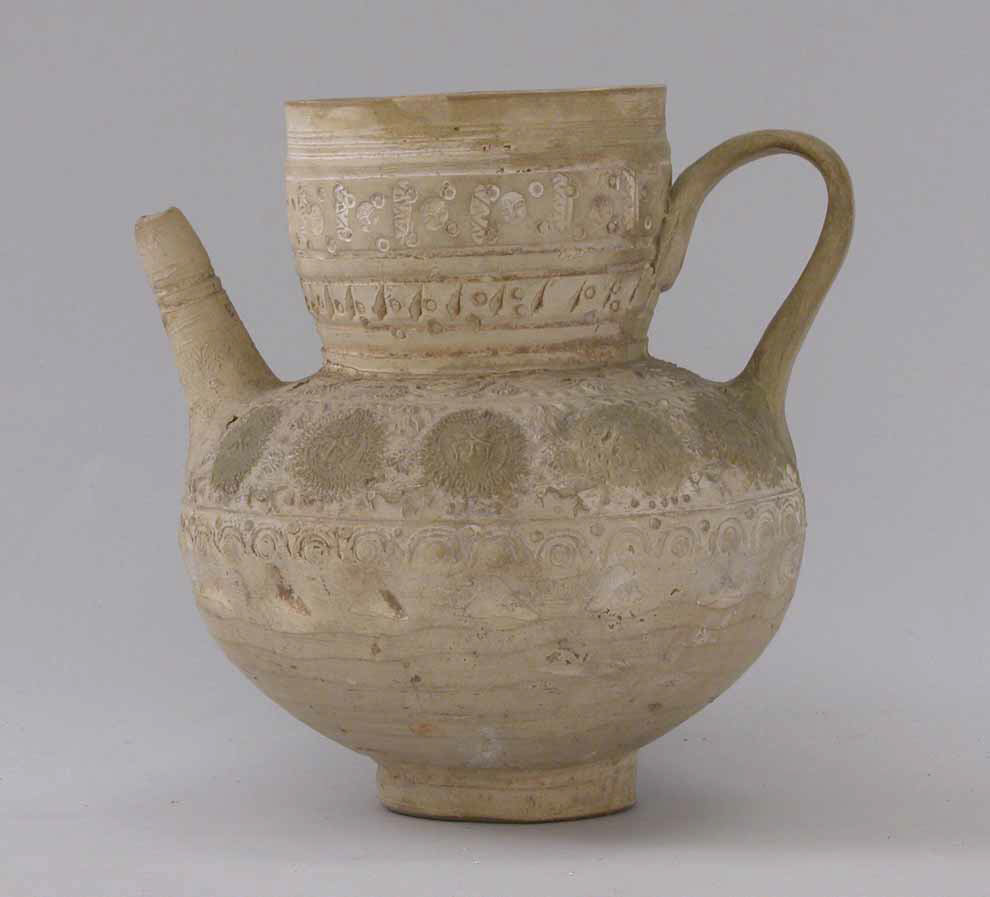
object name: ewer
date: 1001-1200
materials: earthenware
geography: iraq